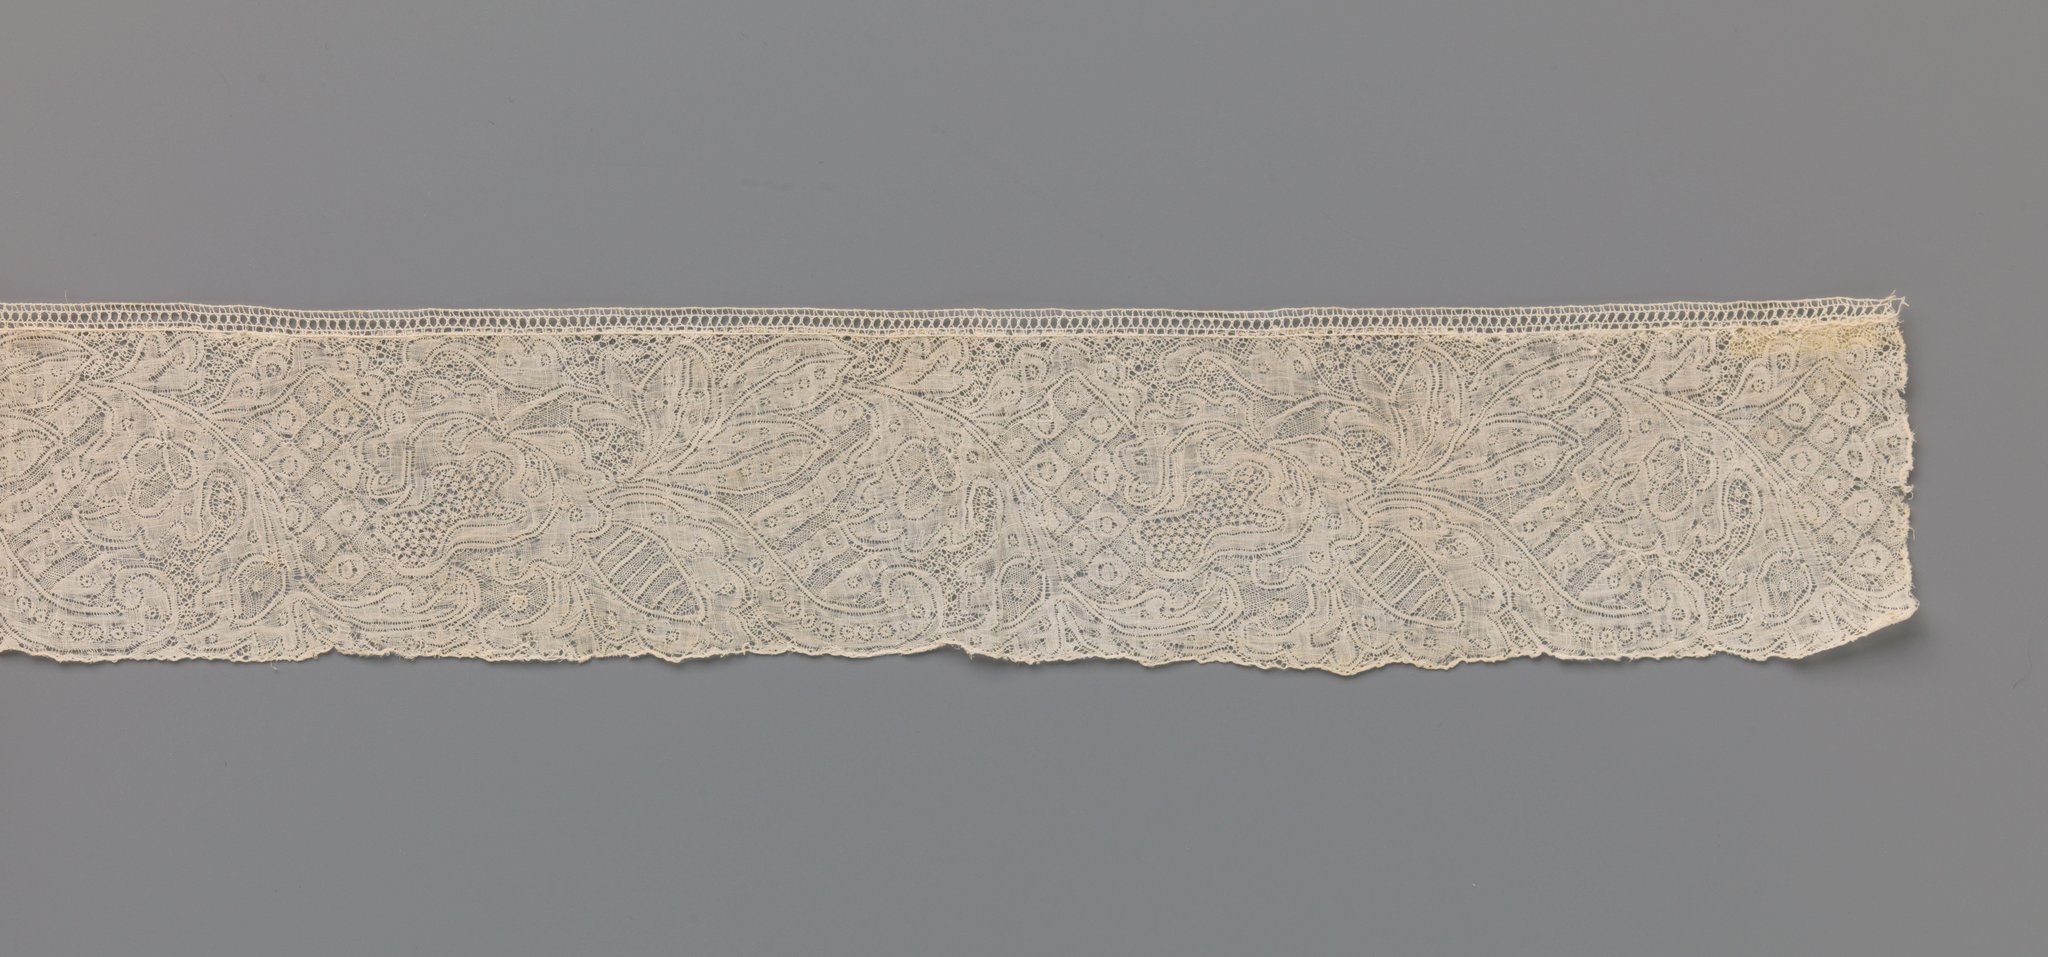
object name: strip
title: Strook kloskant met hangende peervormige bloem en strepen- en ruitenpatroon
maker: Anonymous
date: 1720-1740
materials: linen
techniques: lace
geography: binche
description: Strook naturelkleurige kloskant, Binche-kant. Het zich herhalende patroon bestaat uit een schuin naar beneden hangende peervormige bloem, met een gelobde rand om het bolle gedeelte heen. Het spitsvormige blad schuin eronder wijst de andere kant op en heeft ook een gelobde rand, waarlangs aan de bovenkant een lint met omkrullend uiteinde naar beneden glijdt. Vanaf het lint tot aan de volgende peervormige bloem is het patroon opgevuld met schuine strepen en ruitjes. De strepen en ruitjes worden door een grillig blad gescheiden, die vanaf de bovenkant van het patroon schuin naar beneden afhangt. De motieven staan tegen elkaar aan en overlappen elkaar gedeeltelijk. Waar ze elkaar niet raken, zijn ze met elkaar verbonden door een fijne siergrond, een sneeuwvlokkengrond, die ook als siergrond in de bloem is toegepast. De motieven zijn gemaakt in linnenslag en netslag met opengewerkte randjes en met losse sneeuwvlokken. De bovenzijde van de strook is afgewerkt met een apart geklost bandje. De onderzijde is min of meer recht afgewerkt.